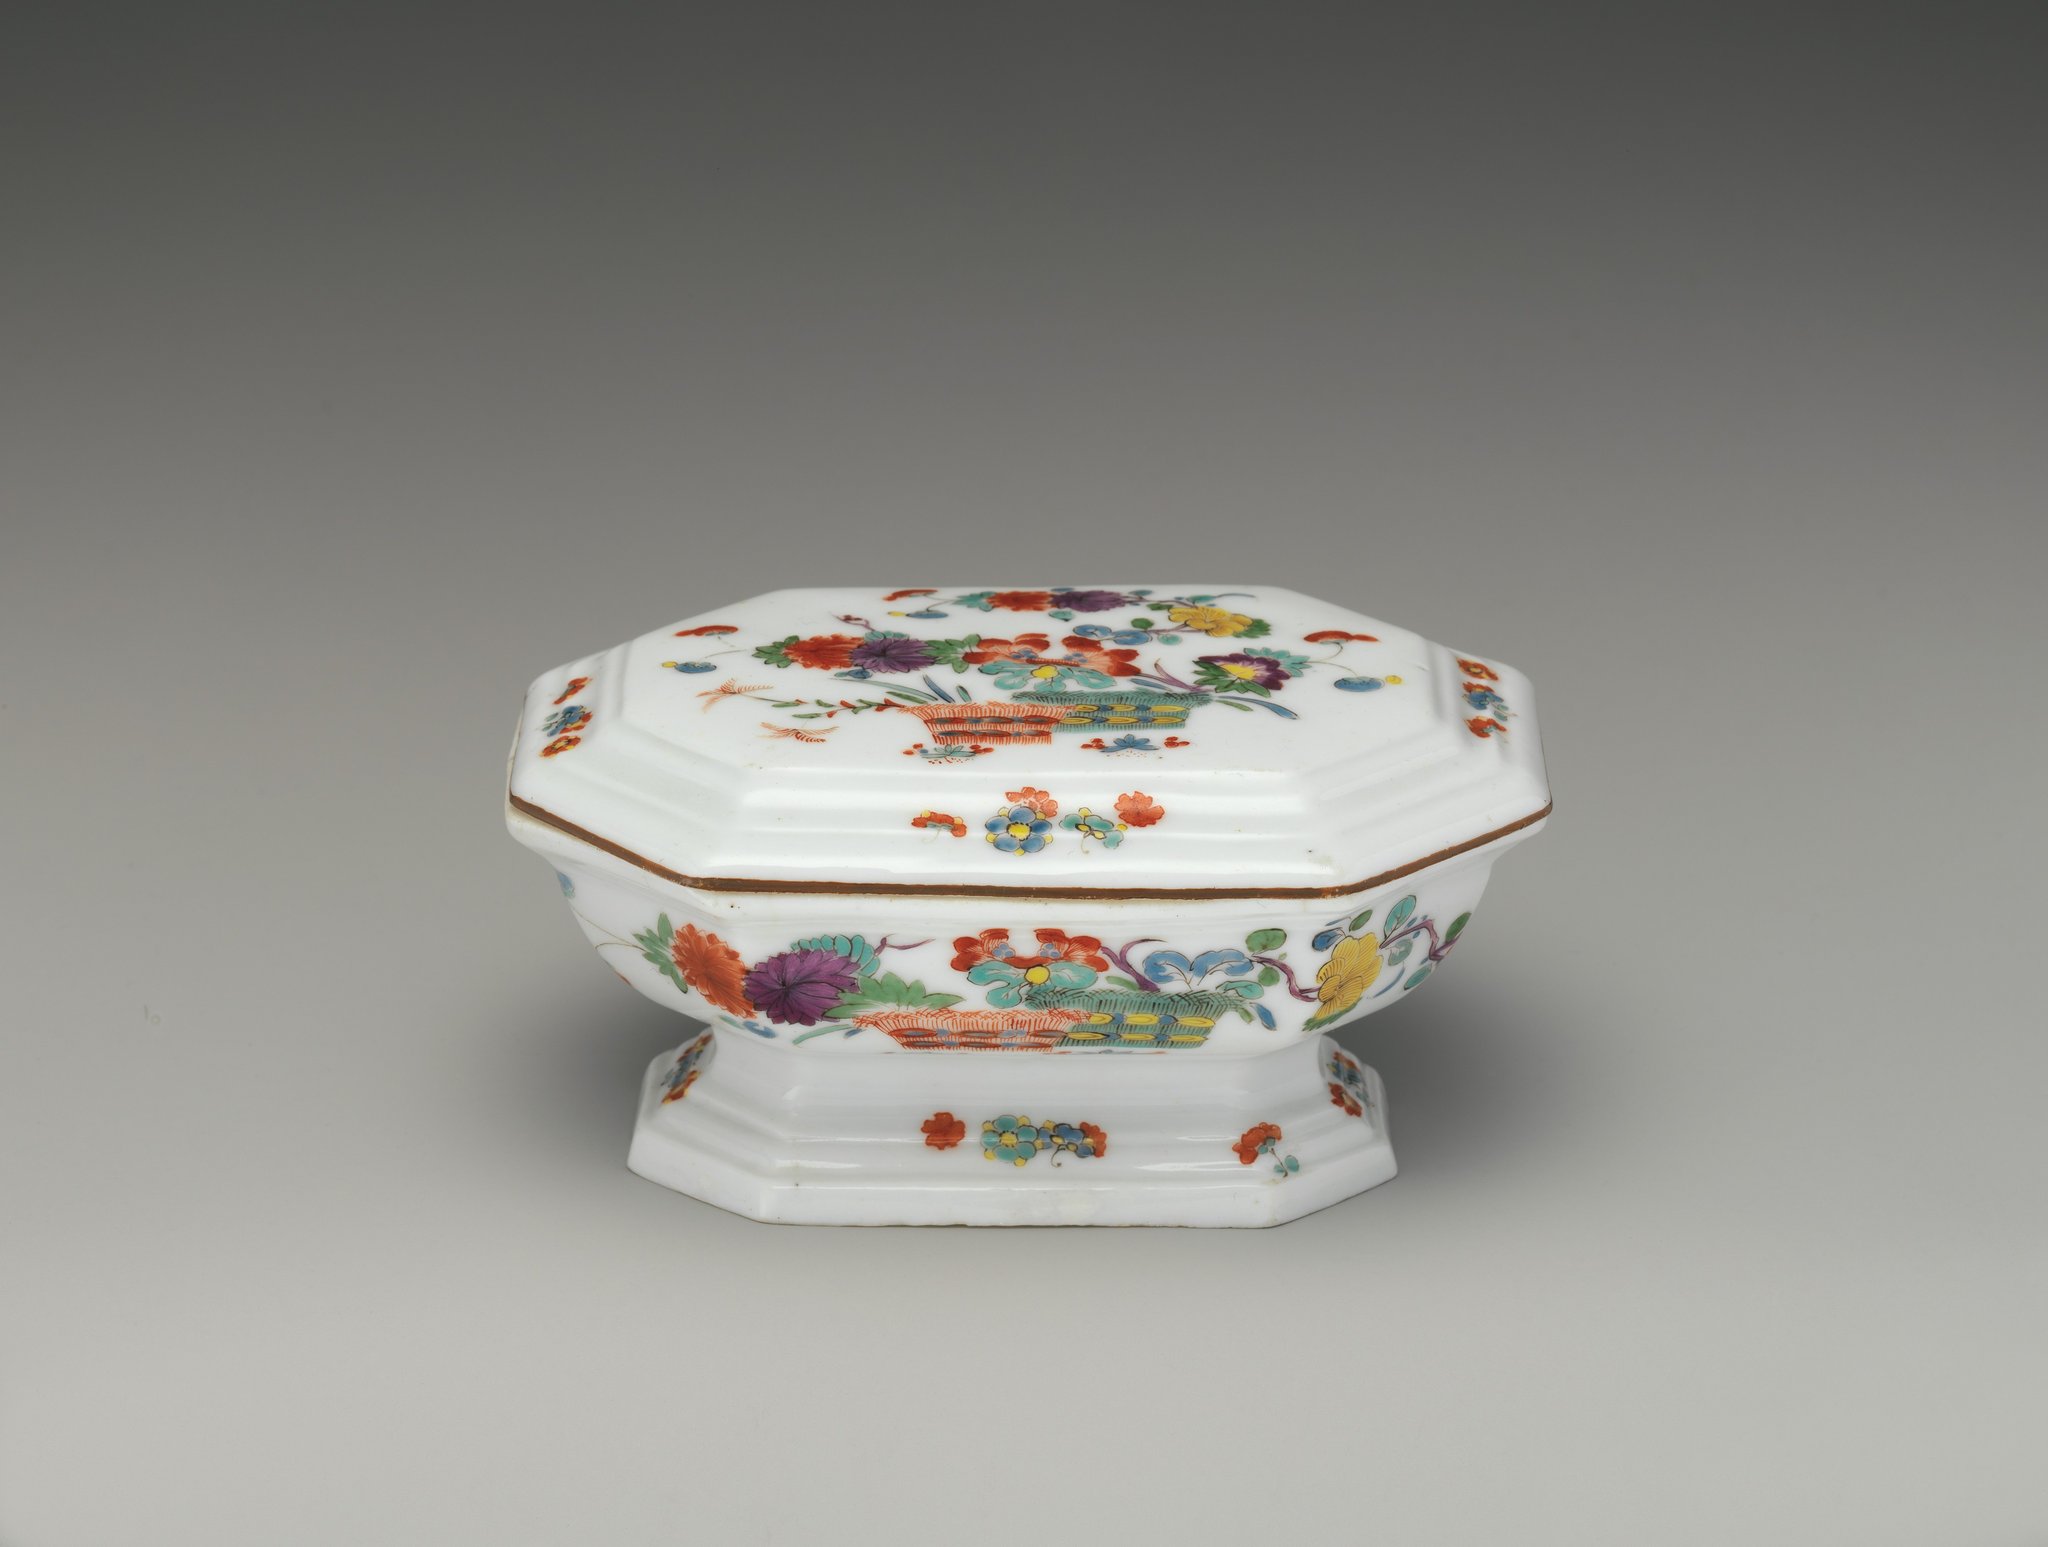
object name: spice box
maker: meissen manufactory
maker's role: manufactory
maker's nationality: german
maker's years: 1710-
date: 1730-1735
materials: hard paste porcelain, silver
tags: flowers